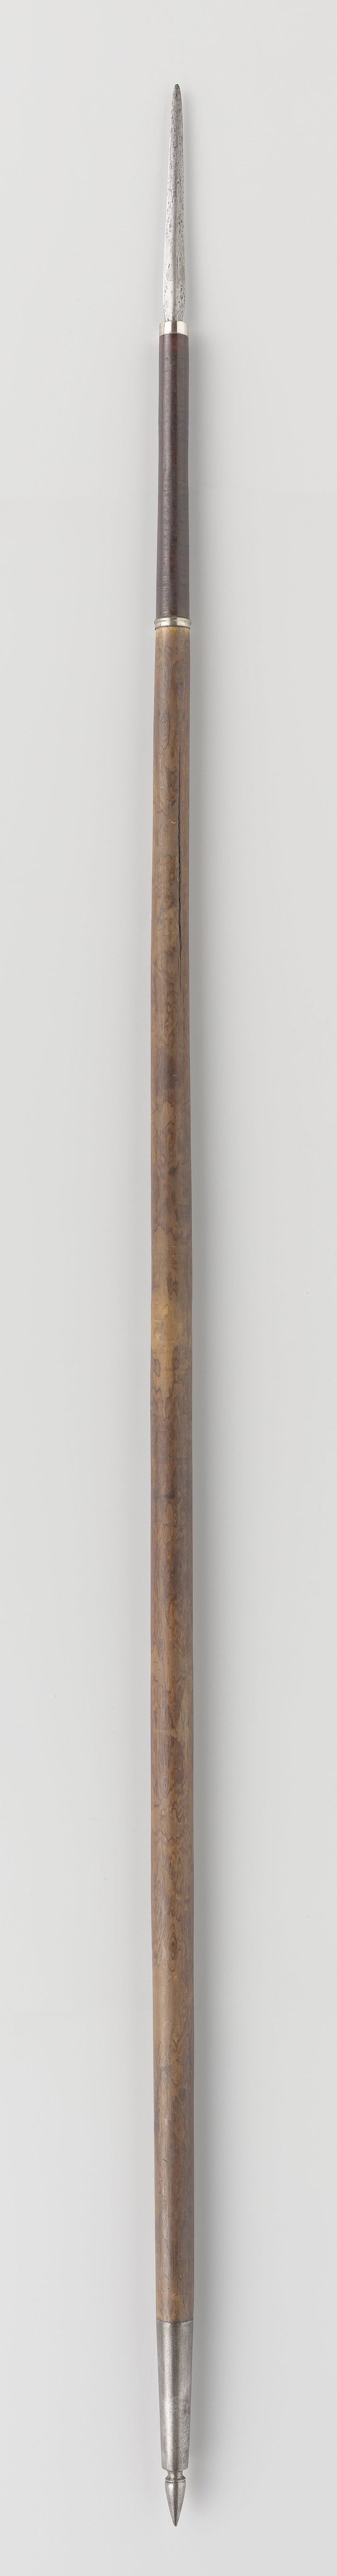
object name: pike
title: Lans uit het wapenrek van Gouverneur-Generaal J.C. baron Baud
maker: Anonymous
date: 1800-1900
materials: iron, fiber, wood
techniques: casting, cutting, forging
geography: kalimantan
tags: the hague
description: Ronde houten schacht met aan onderzijde ijzeren omhulsel uitlopend in een kegelvormige punt. Bovenzijde van schacht is omwikkeld met touw waaromheen een ijzeren ring. Korte smalle kling, uitlopend in een spitse punt. Versiering (gewaterd staal) op kling.